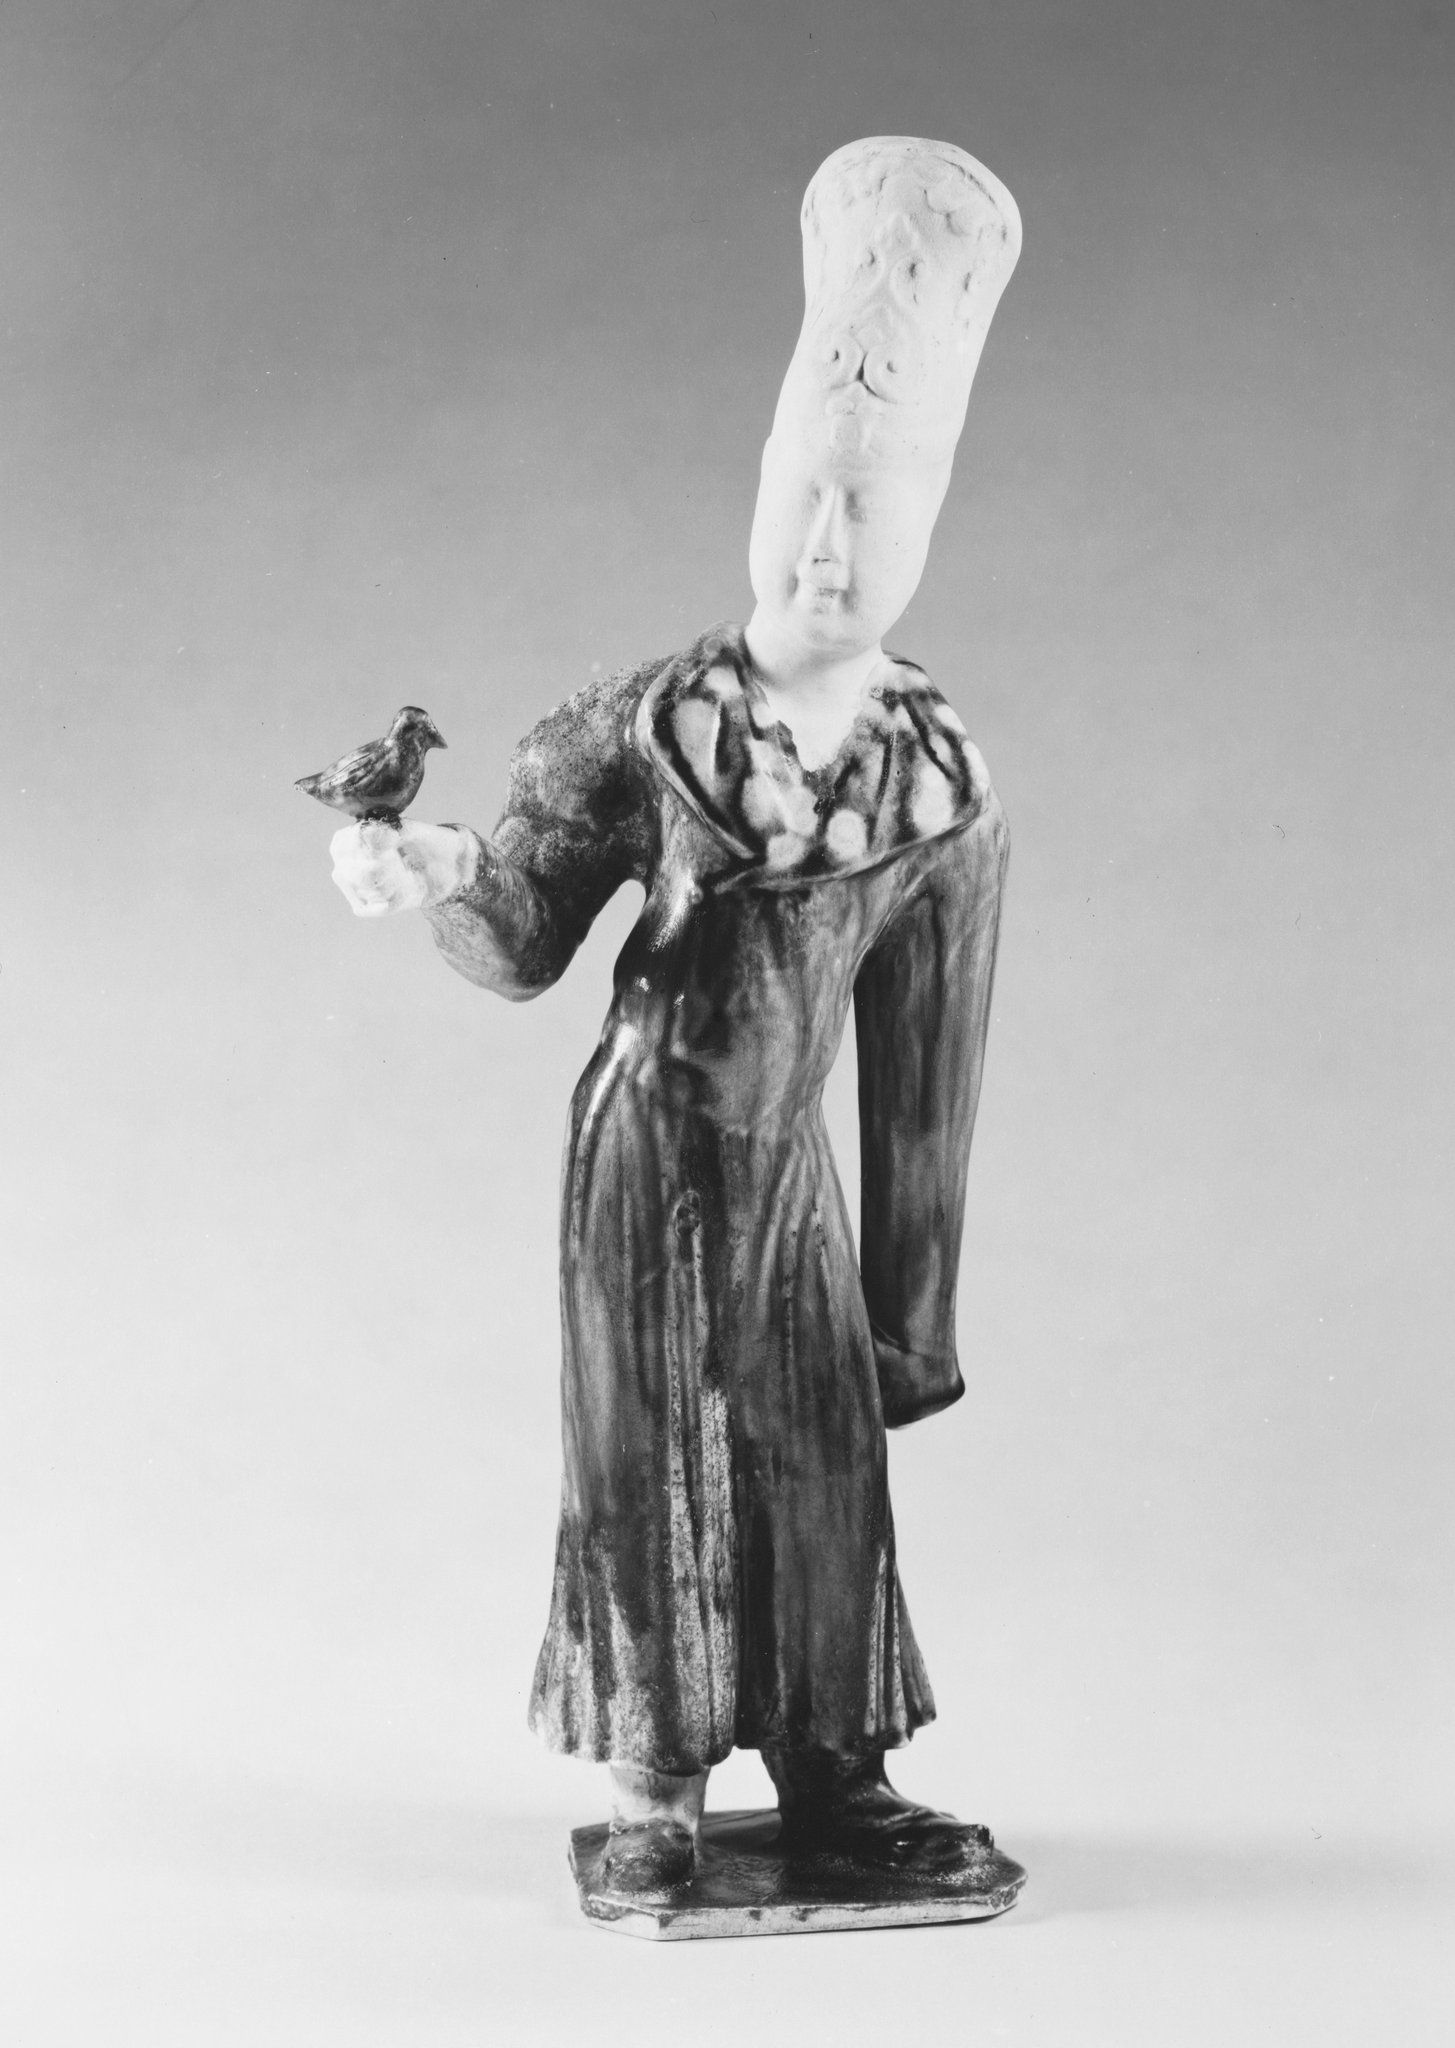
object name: figure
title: Male attendant holding a bird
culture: chinese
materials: earthenware, glaze, pigment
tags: birds,hats,men